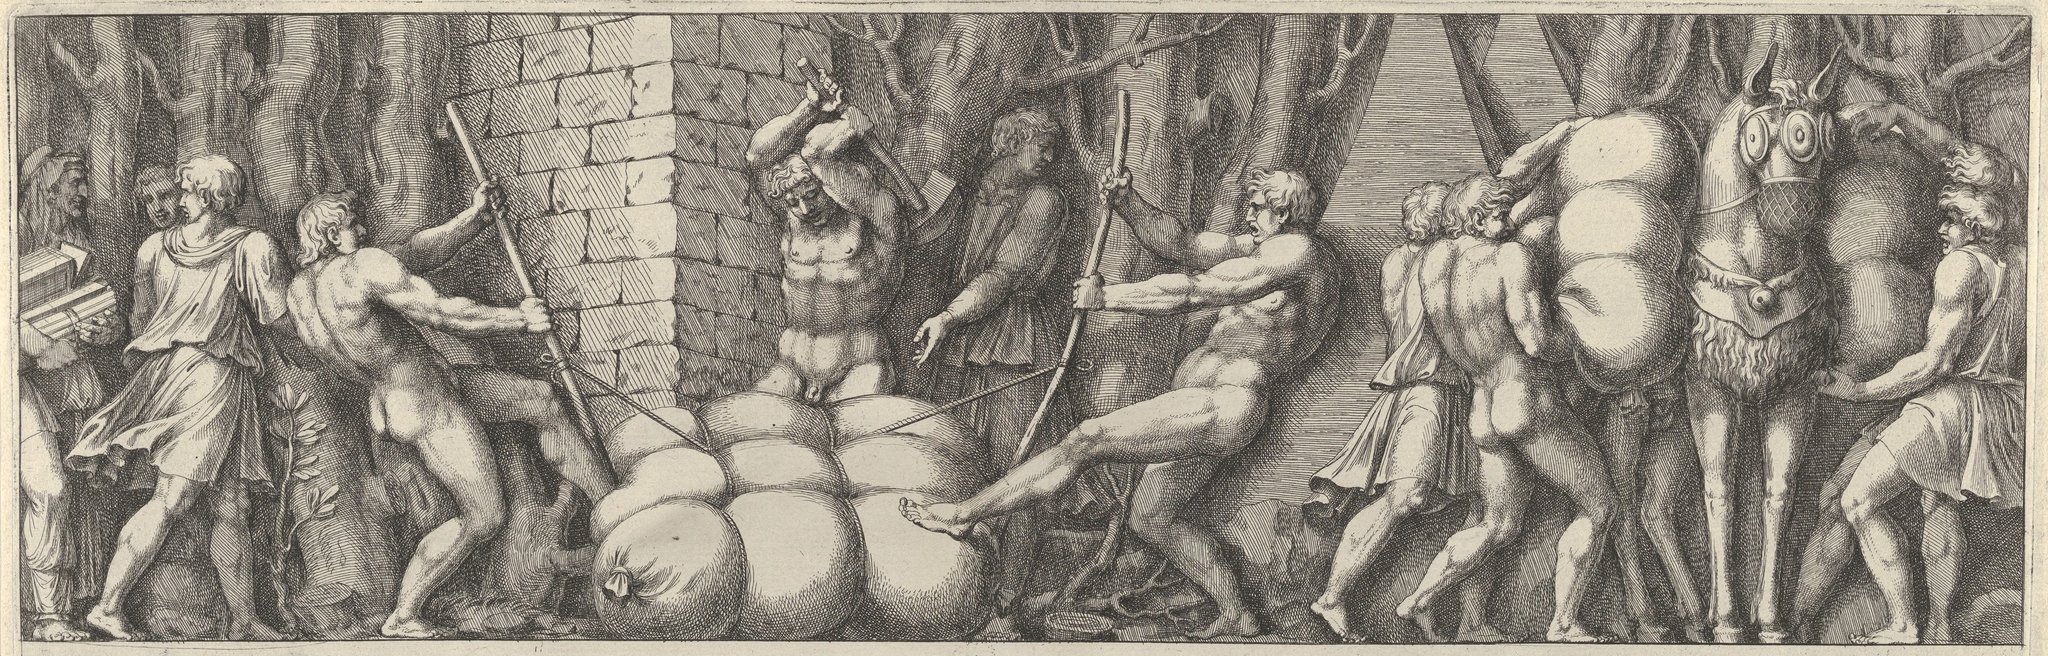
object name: print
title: Plate 2: various figures carrying out tasks that include tying a sack and loading a horse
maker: pietro santi bartoli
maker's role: artist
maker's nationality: italian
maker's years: 1615-1700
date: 1660-1690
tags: men,male nudes,horses,working